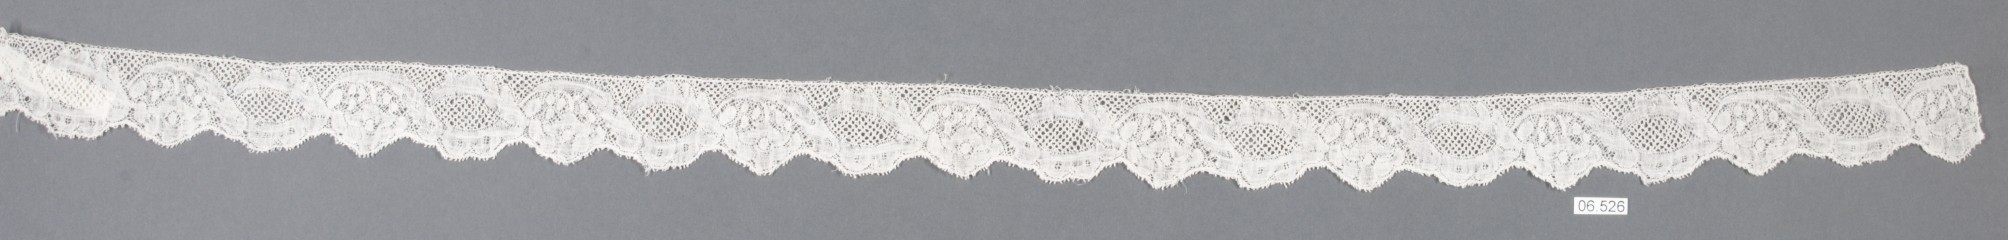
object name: strip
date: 1701-1733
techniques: lace